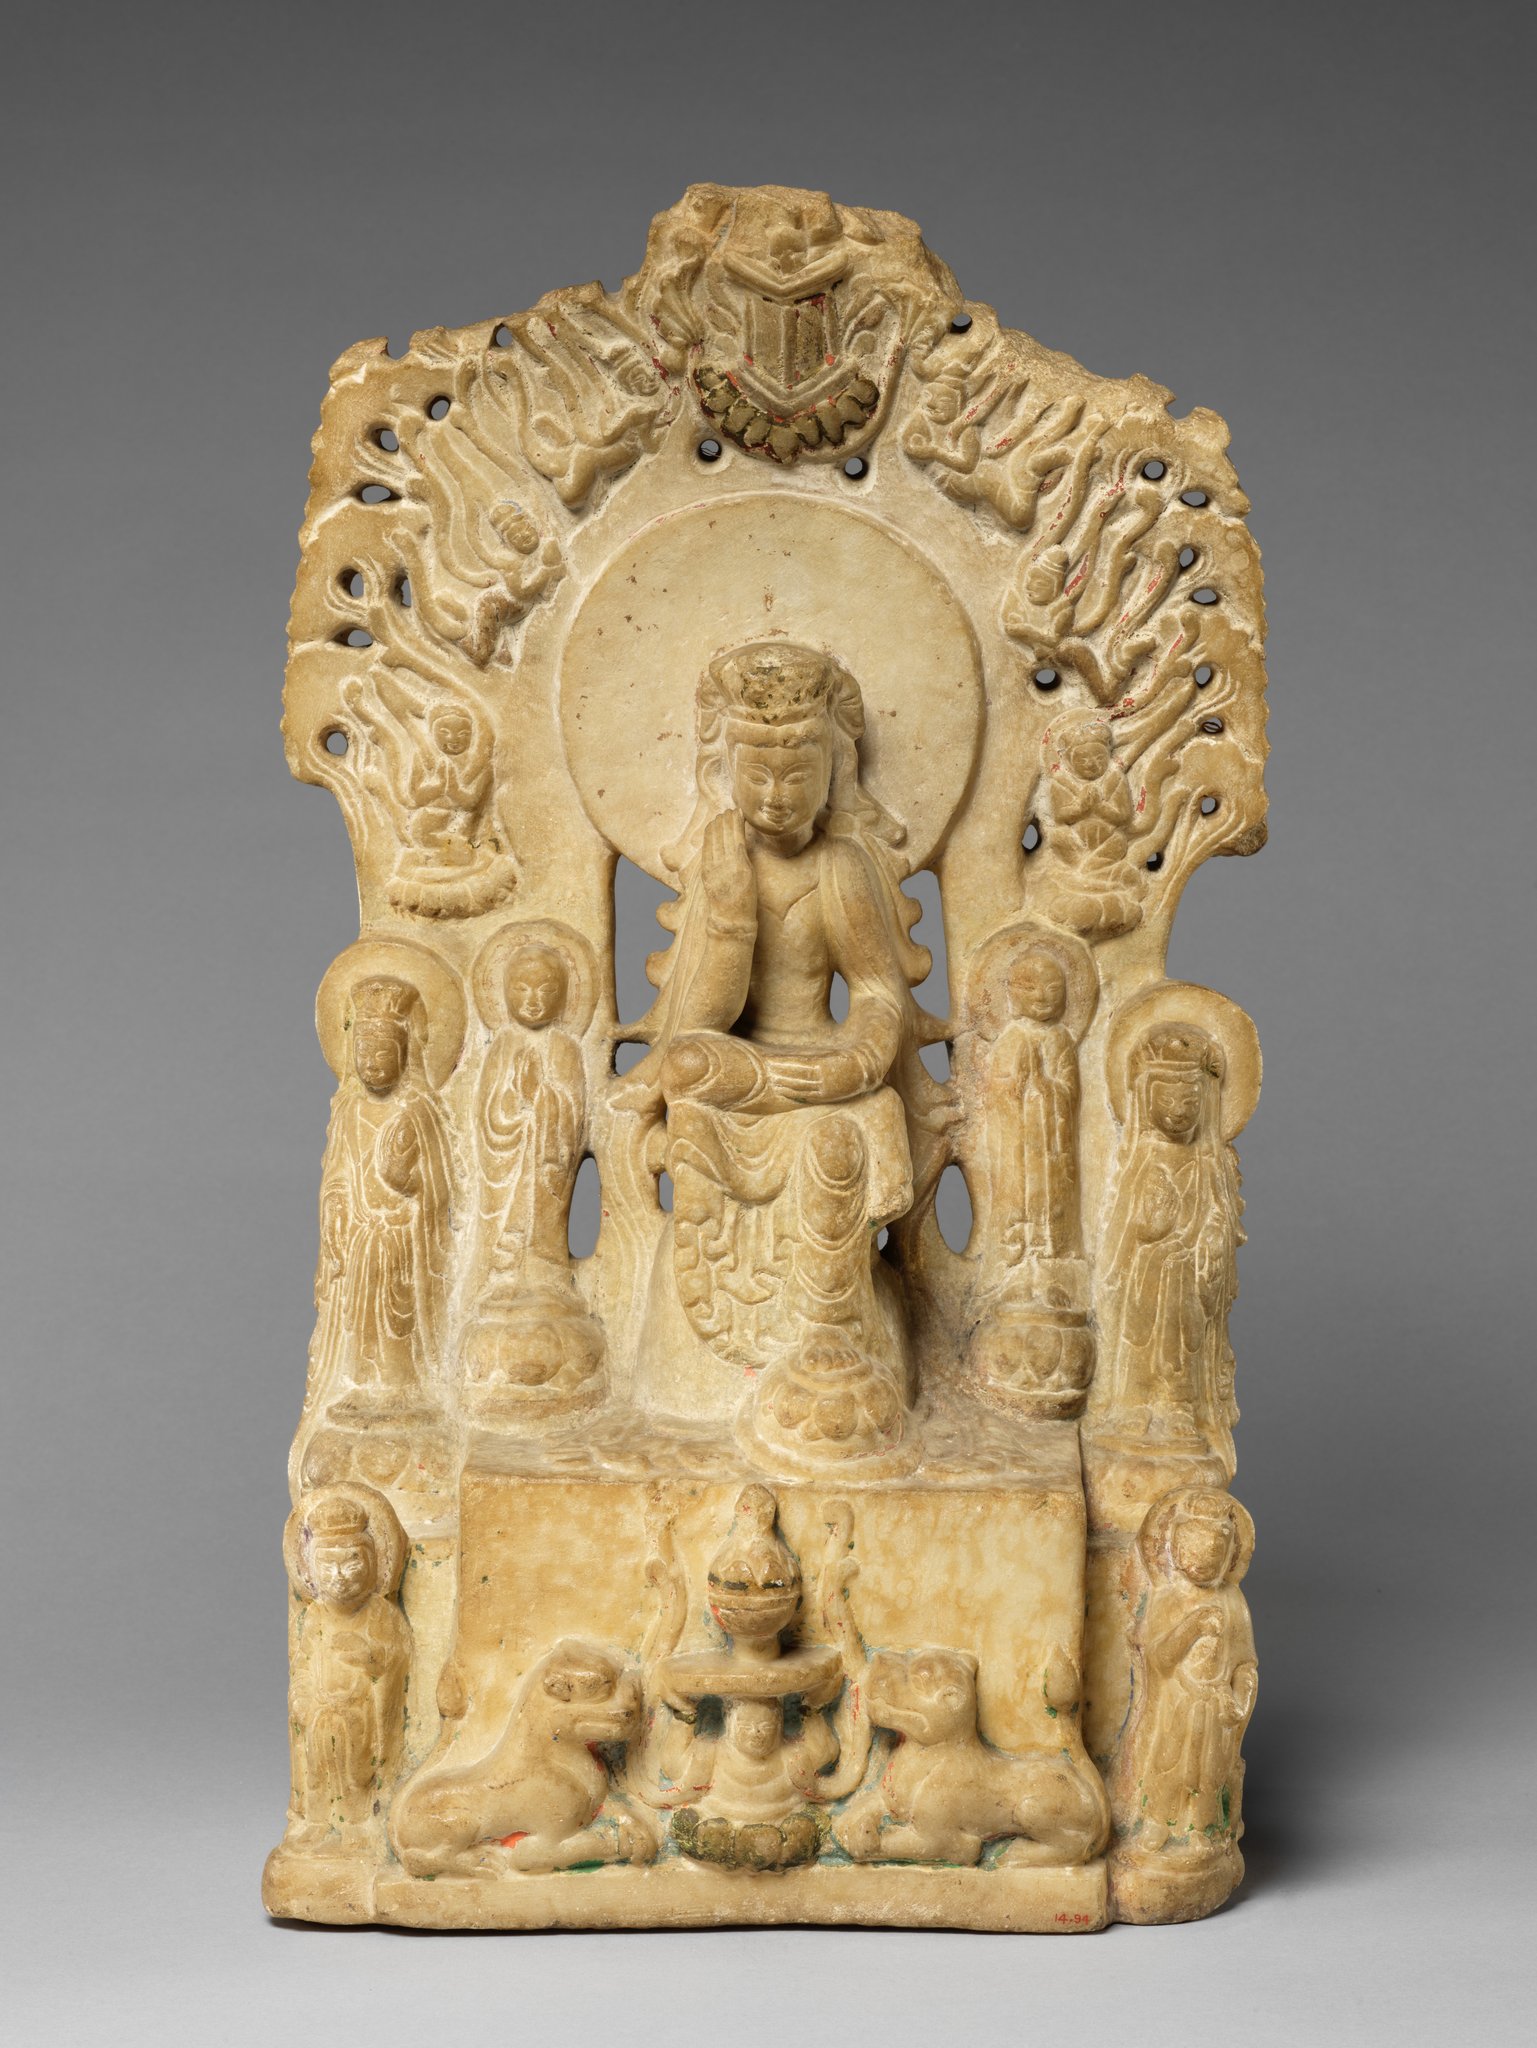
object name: stele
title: Stele with seated Buddha (Maitreya) and attendant bodhisattvas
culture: chinese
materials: alabaster